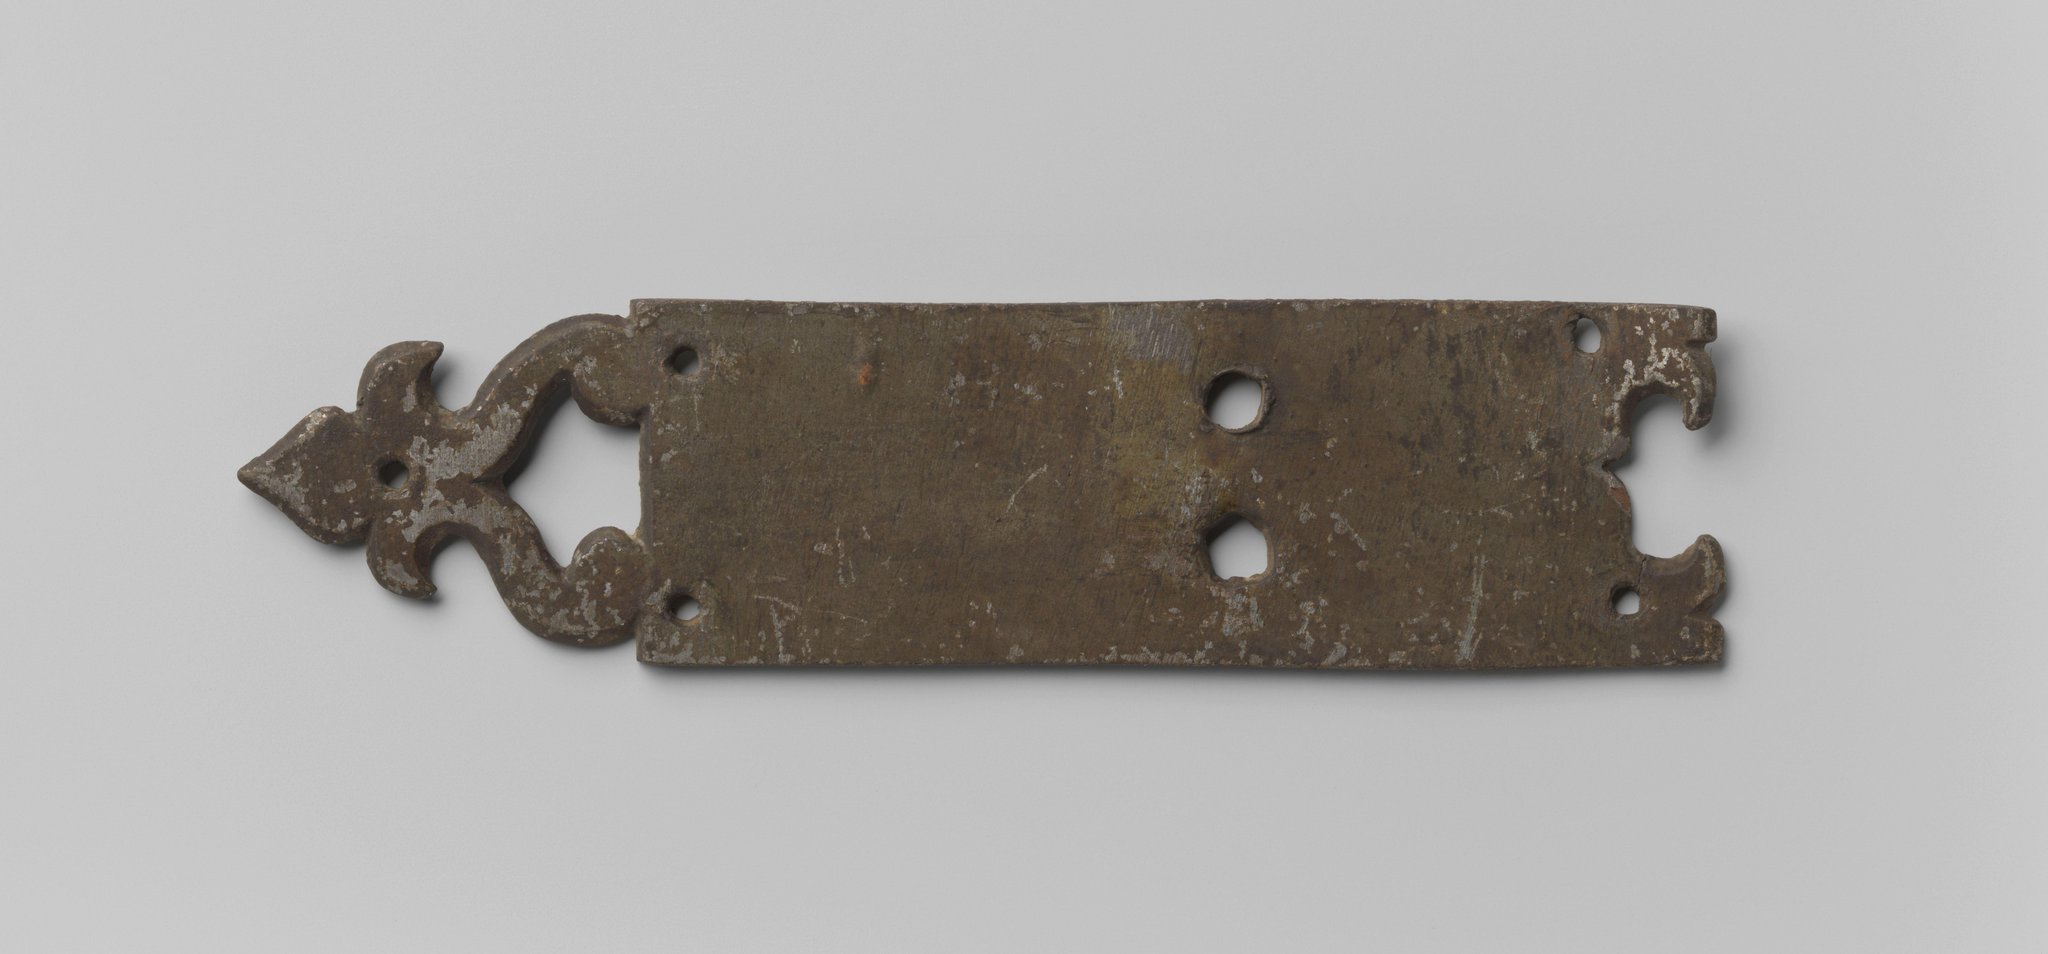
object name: knip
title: Beslag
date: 1400-1950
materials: iron